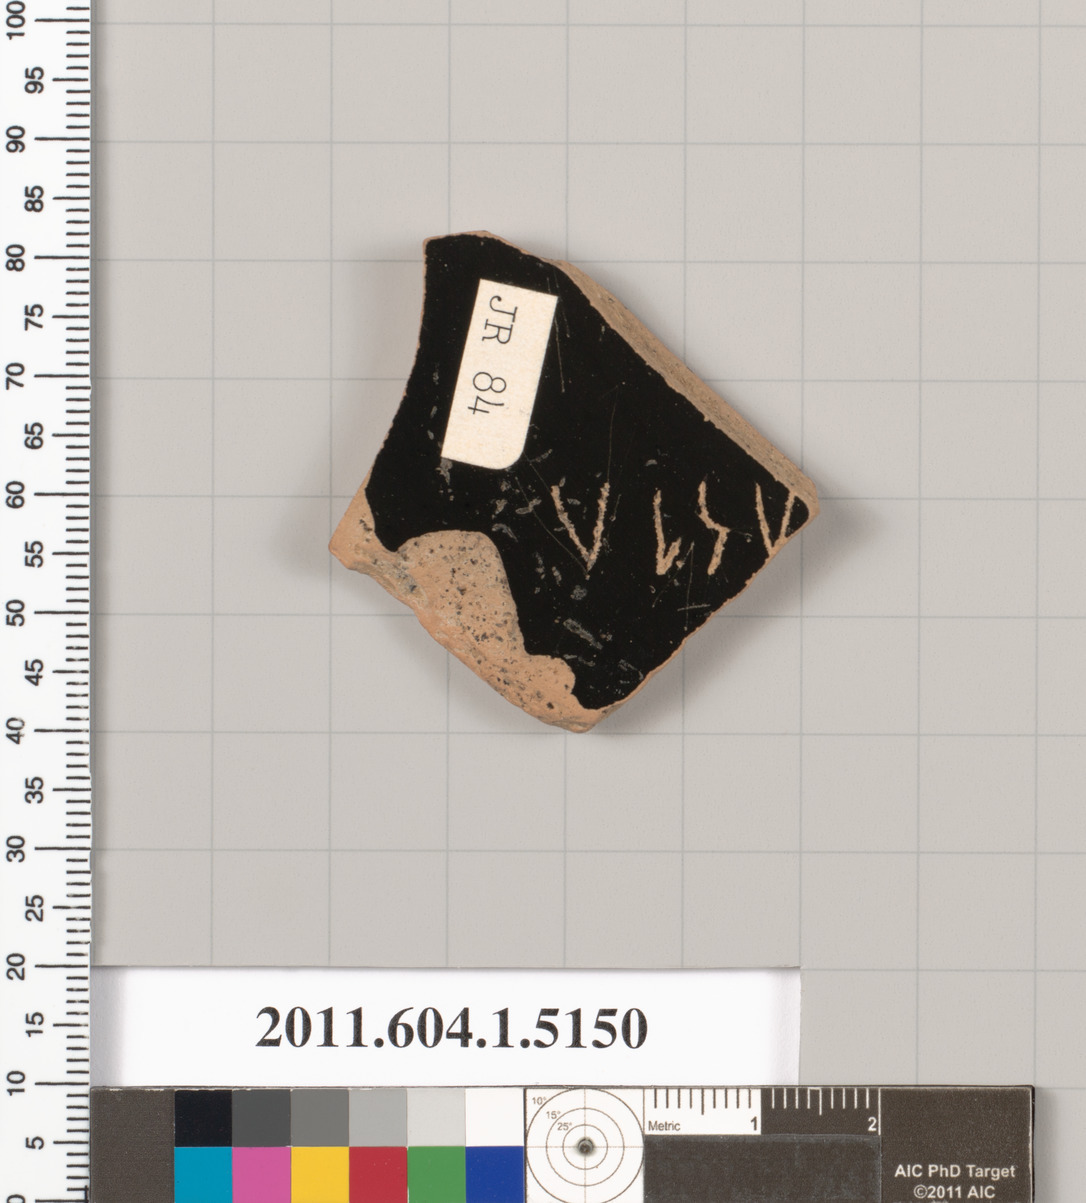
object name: kylix fragment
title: Terracotta fragment of a kylix (drinking cup)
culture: greek, attic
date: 500-480 BCE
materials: terracotta